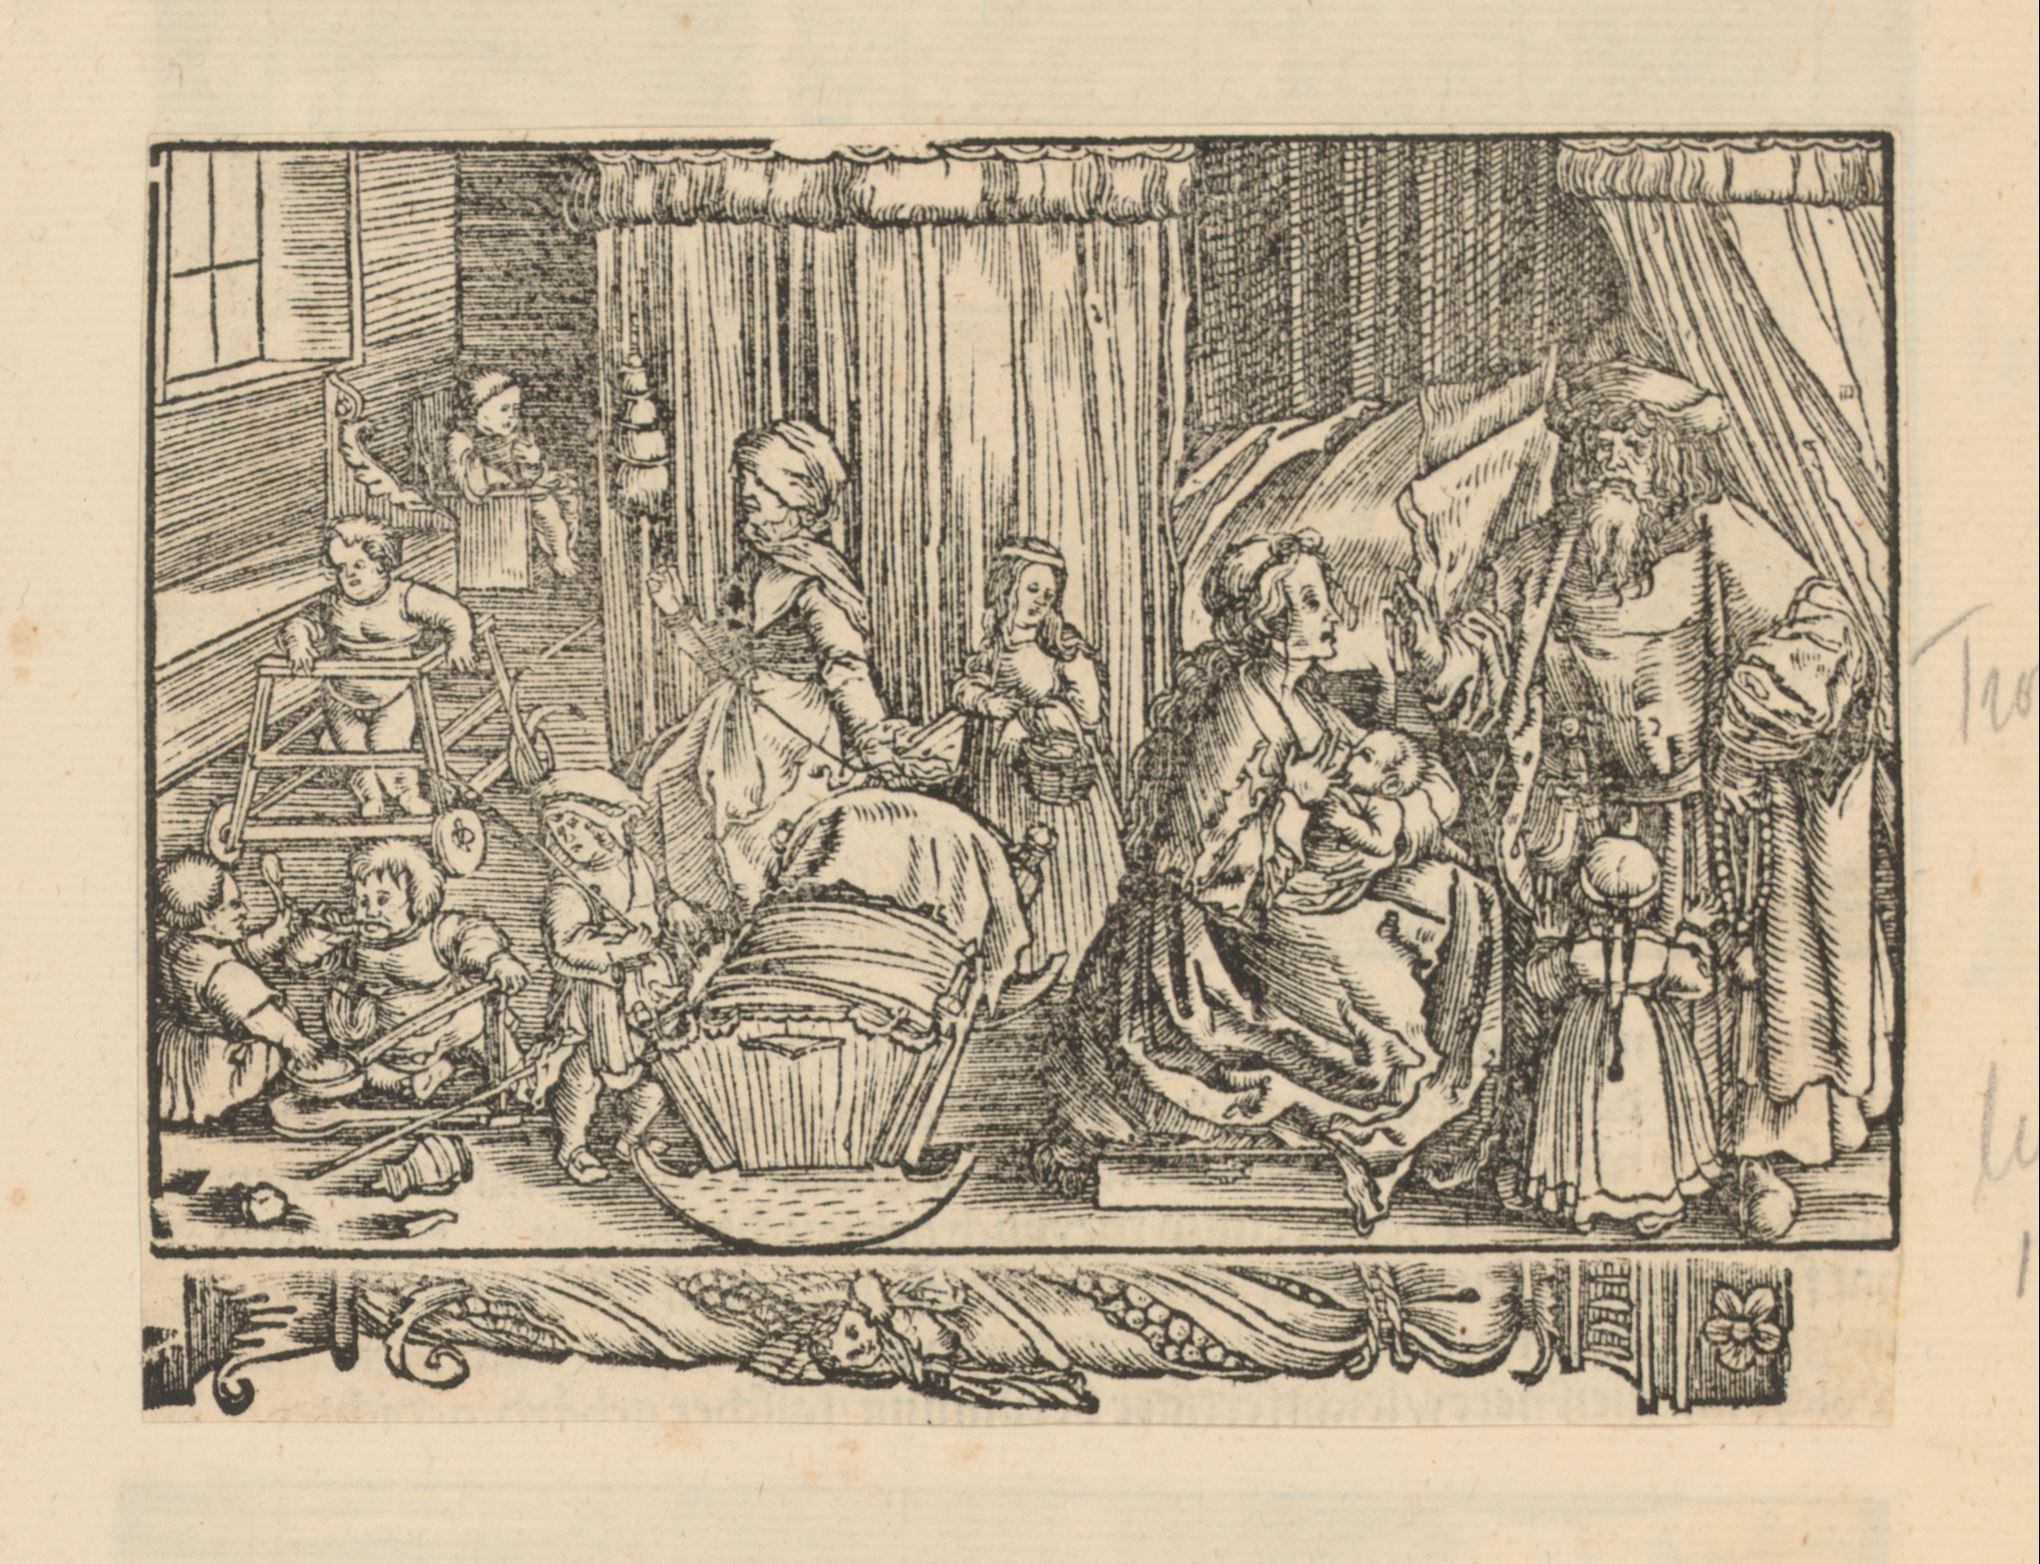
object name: album leaf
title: Grote familie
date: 1514-1532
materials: paper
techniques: letterpress printing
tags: family life at home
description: Deze prent is gebruikt in: Petrarca, Francesco. Von der Artzney bayder Glück, des guten und widerwertigen: unnd weß sich ain yeder inn Gelück und Unglück halten sol (...). Augsburg: Heinrich Steiner, 1532. Deze uitgave is ook bekend onder de titel 'Trostspiegel in Glück und Unglück'. Deze prent is ook gebruikt in: Cicero, Marcus Tulius. Officia M.T.C. Ein Buch so Marcus Tullius Cicero der Römer zu seynem (...). [Vertaald uit het Latijn door] Johann von Schwarzenberg. Augsburg: Heinrich Steiner, 1531.